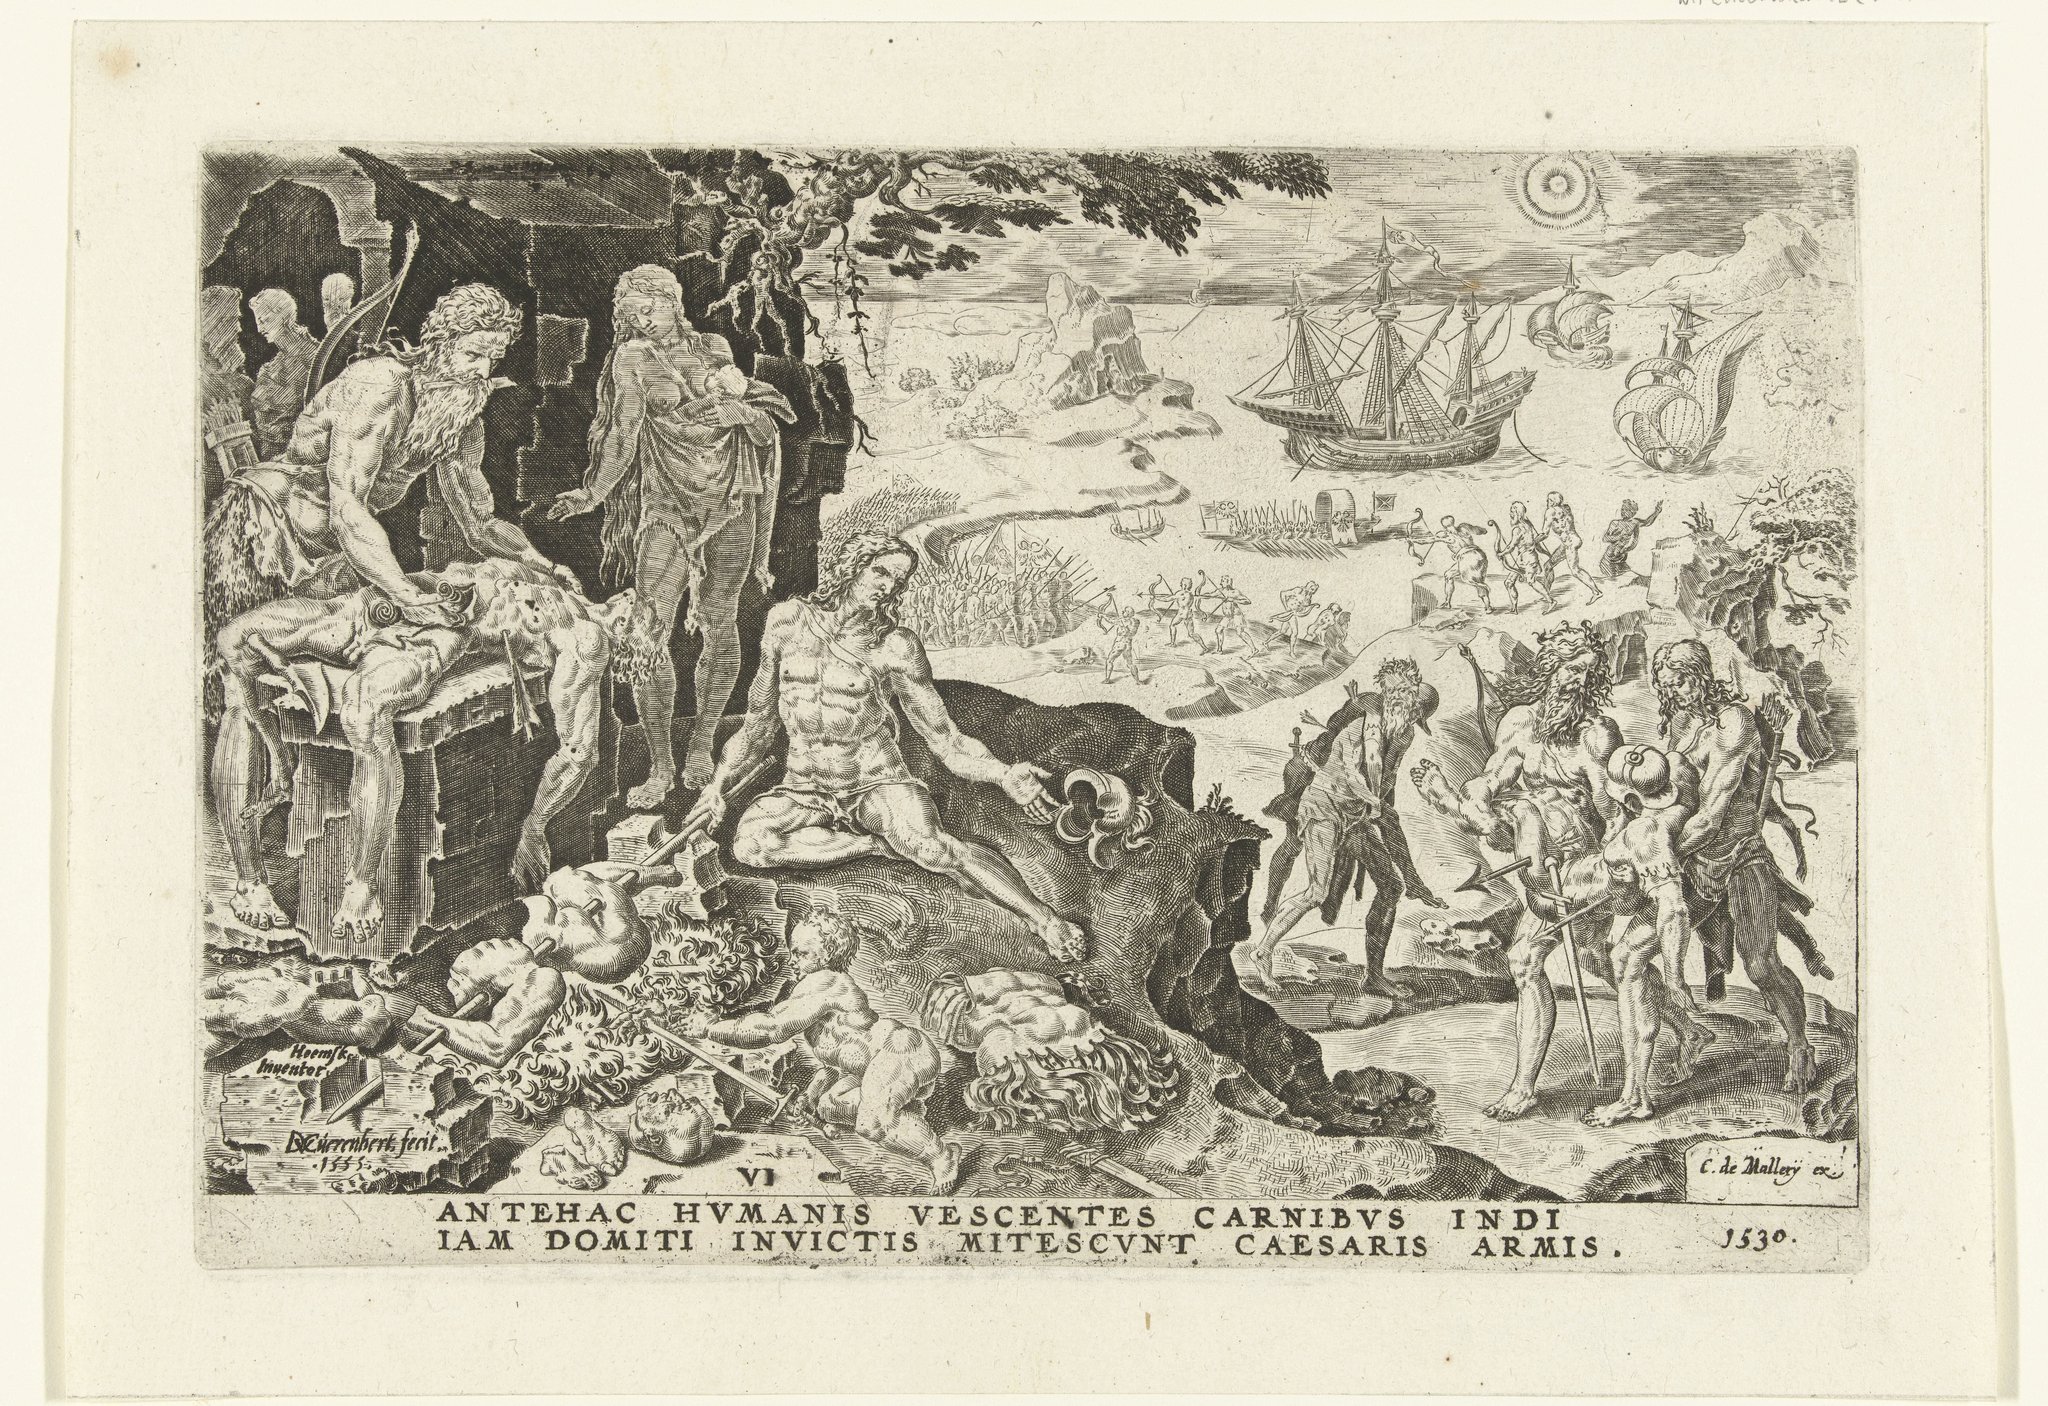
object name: history print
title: Overwinningen van Karel V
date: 1555-1556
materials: paper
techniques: engraving, etching, letterpress printing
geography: haarlem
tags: charles v (holy roman emperor and king of spain), battle, indigenous peoples of central america, cannibalism, violent death by disembowelment, pulling out of intestines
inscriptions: collector's mark: Lugt 2228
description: Keizerlijke troepen van Karel V vallen Centraal-Amerika binnen, 1530. De oorspronkelijke bevolking van toenmalig Nieuw-Spanje, nu Mexico, bedrijft kannibalisme. Op de voorgrond wordt links een Spaanse soldaat ontdaan van zijn organen en worden ledematen van andere soldaten geroosterd. Rechts worden nog twee gedode soldaten naar die plek gebracht. Op de achtergrond vechten Spaanse soldaten en de lokale bevolking een veldslag uit. Onderschrift in twee regels Latijn.